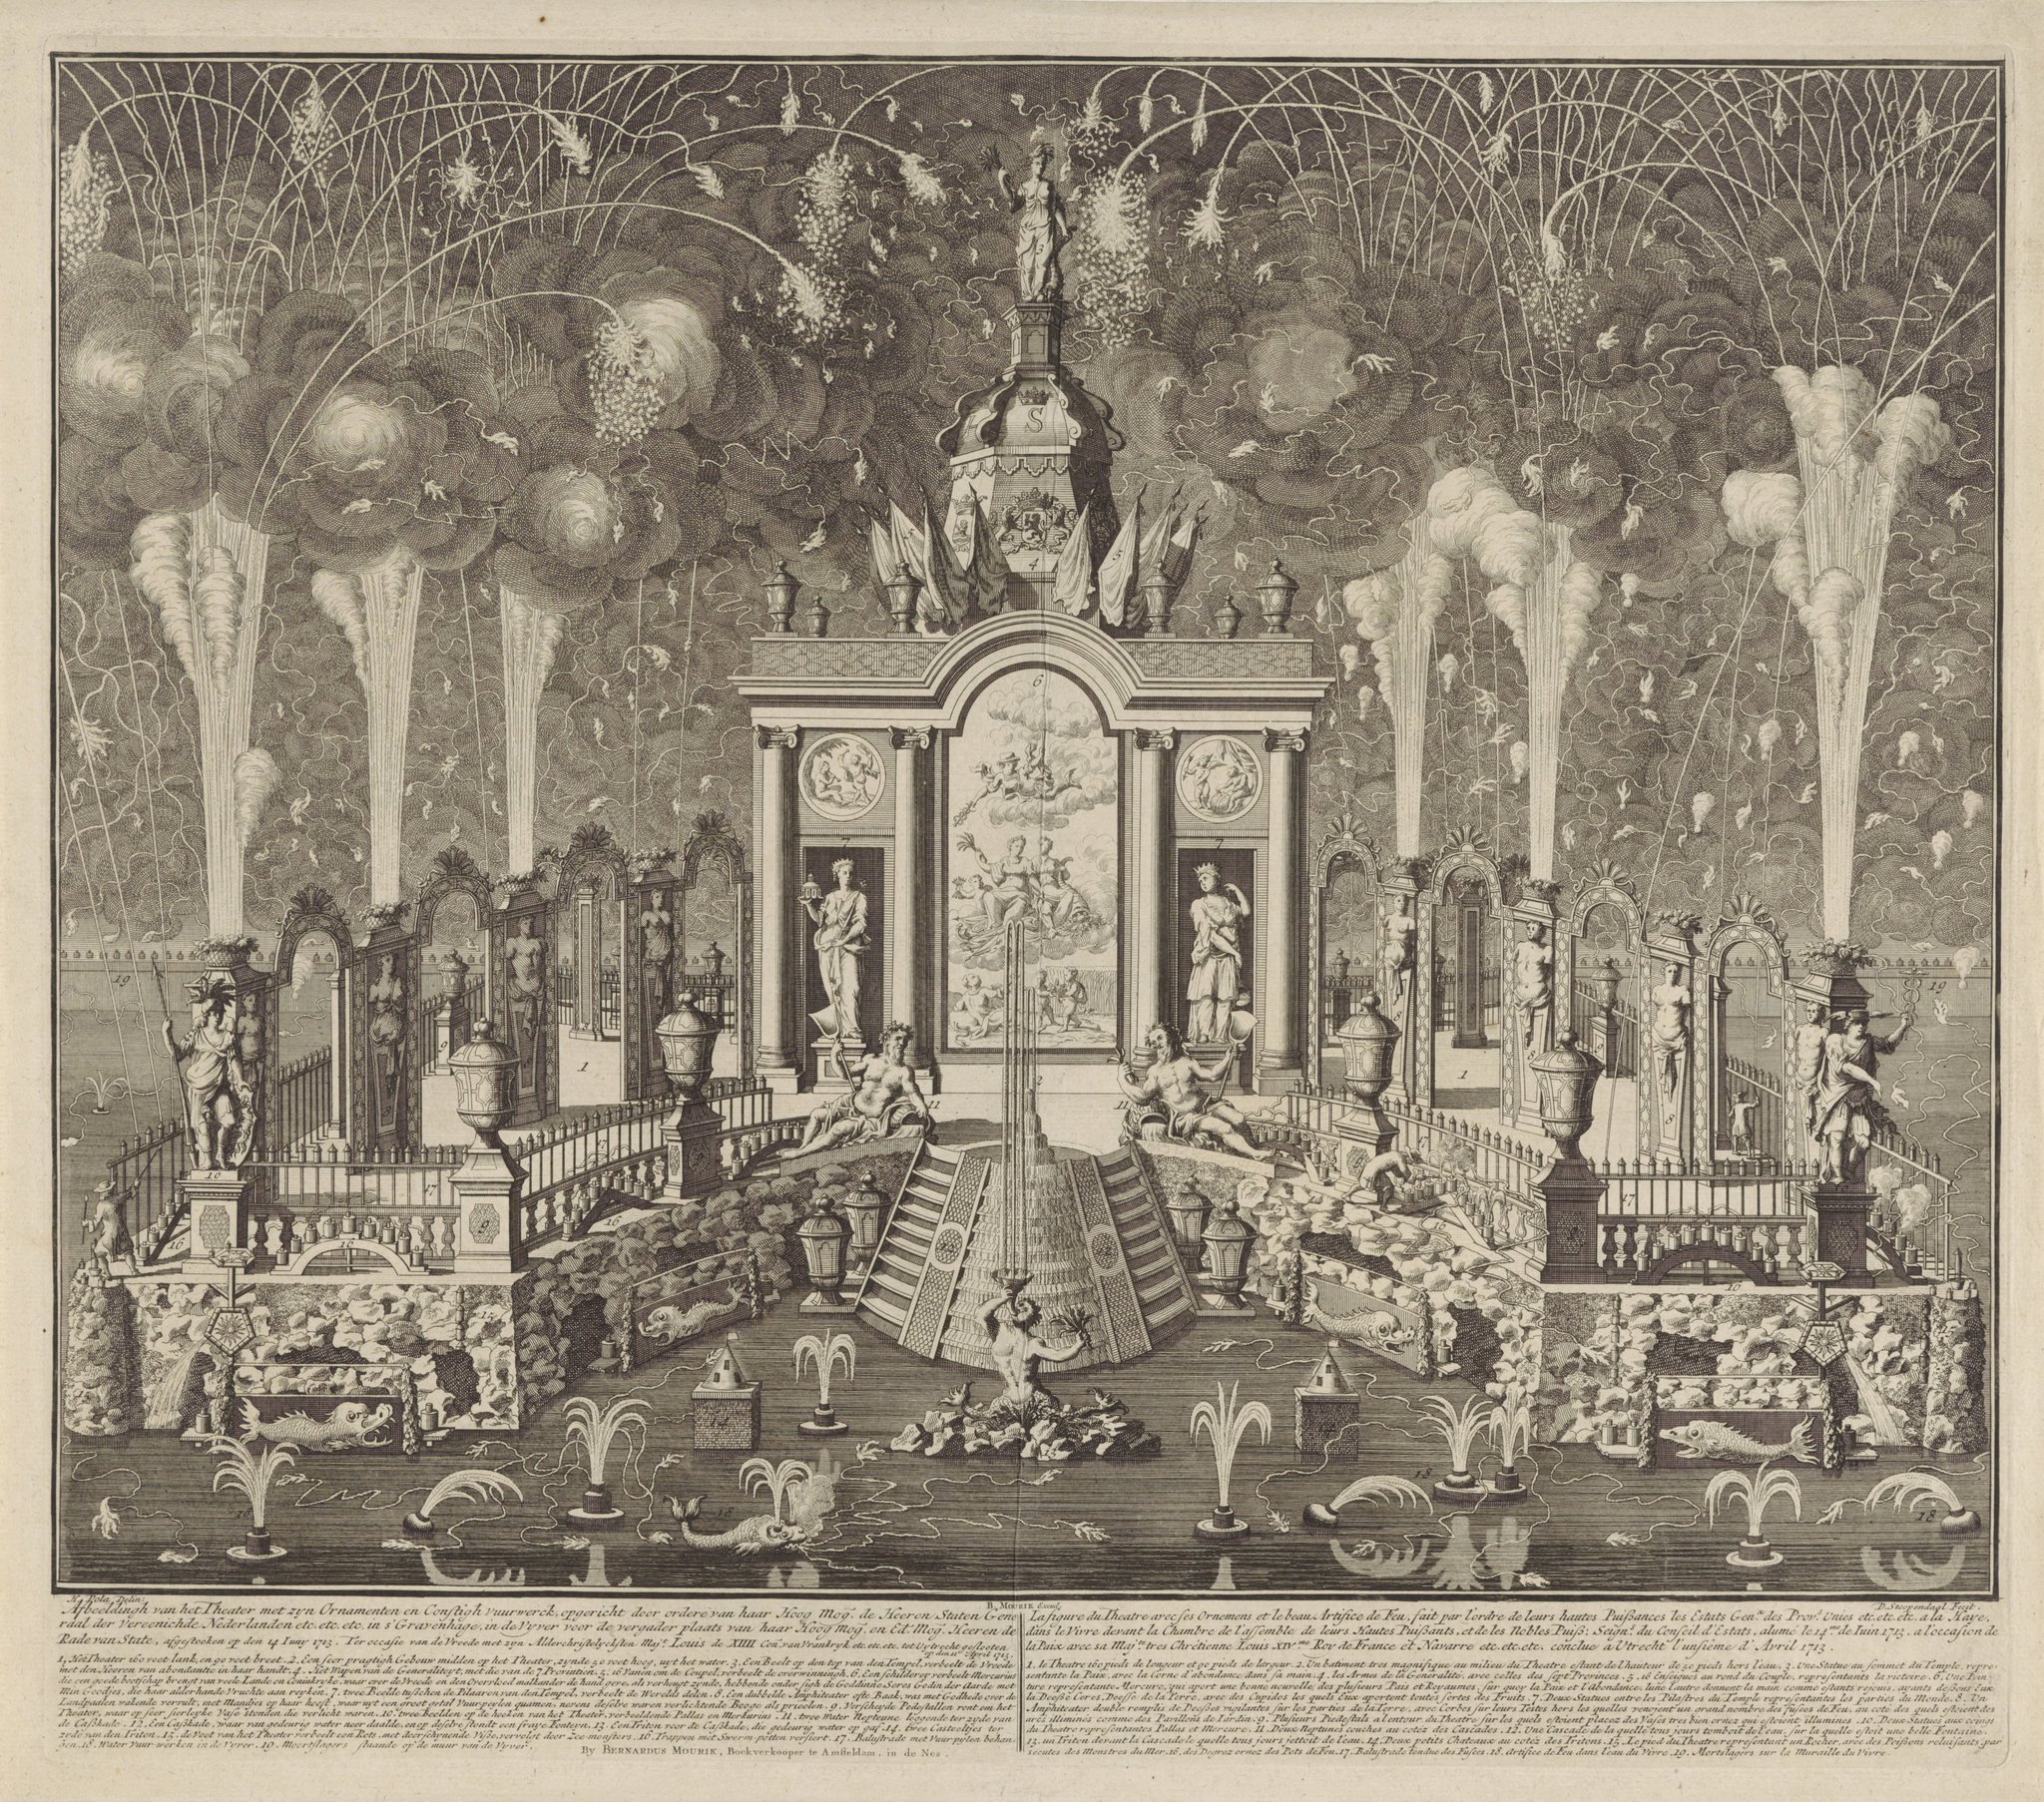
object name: print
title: Vuurwerk bij de viering van de Vrede van Utrecht, 1713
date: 1713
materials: paper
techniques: engraving, etching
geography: amsterdam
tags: bonfire, fire-works, festivities (+ illumination, fire-works ~ festive activities)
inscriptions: collector's mark: Lugt 2228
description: Stellage met vuurwerk afgestoken in opdracht van de Staten-Generaal op de Hofvijver te Den Haag bij de viering van de Vrede van Utrecht, 14 juni 1713. In de vijver is een tempel opgericht met een schilderij waarop Vrede en Overvloed tronen op de wolken en Mercurius een goede tijding brengt. Onderaan de titel en legenda 1-19 in het Nederlands en Frans.